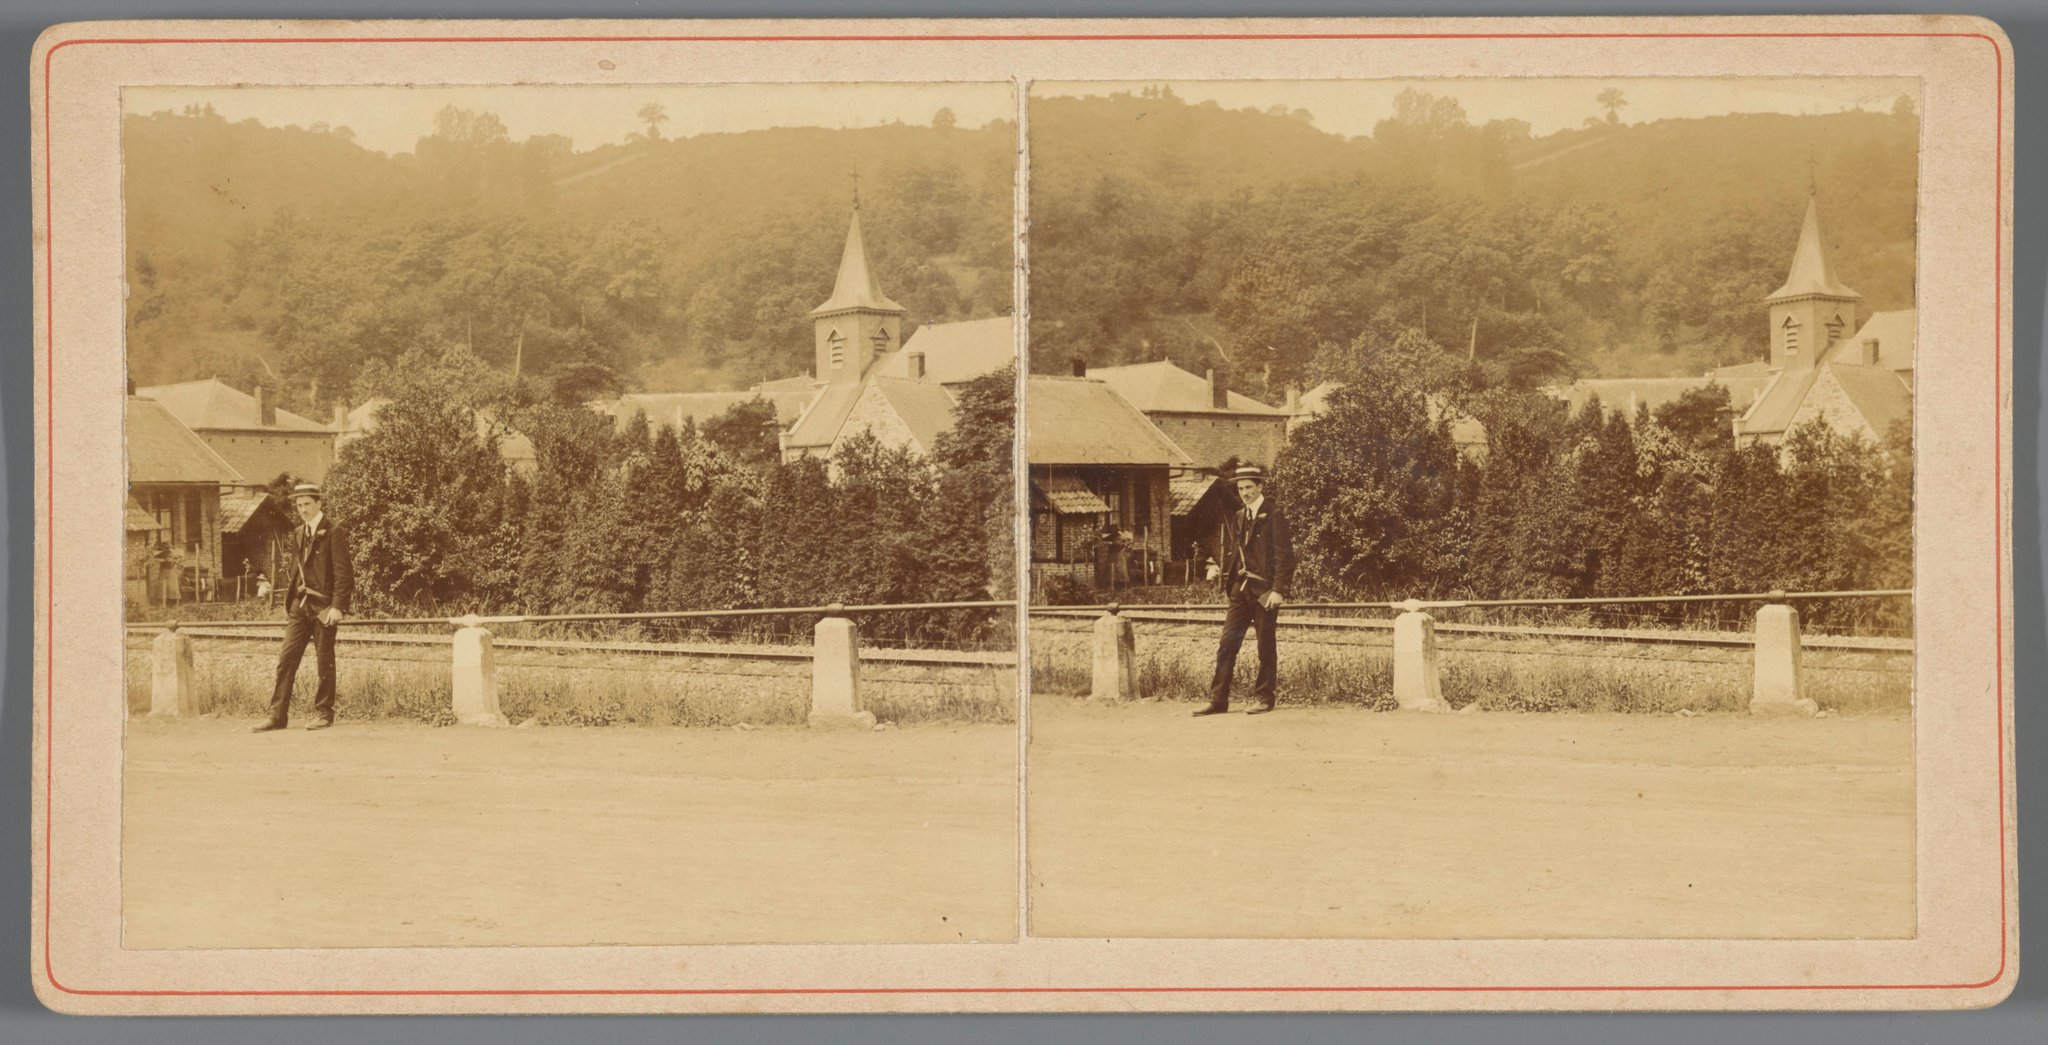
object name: stereograph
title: Waulsort in de Ardennen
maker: Anonymous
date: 1900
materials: cardboard, photographic support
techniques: gelatin silver print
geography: waulsort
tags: waulsort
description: Waulsort in de Ardennen. Een man staande langs de weg. Onderdeel van een groep van 5 foto's en 19 stereofoto's gemaakt door een onbekende amateurfotograaf rond 1900 in Amsterdam, de Ardennen en Denemarken.